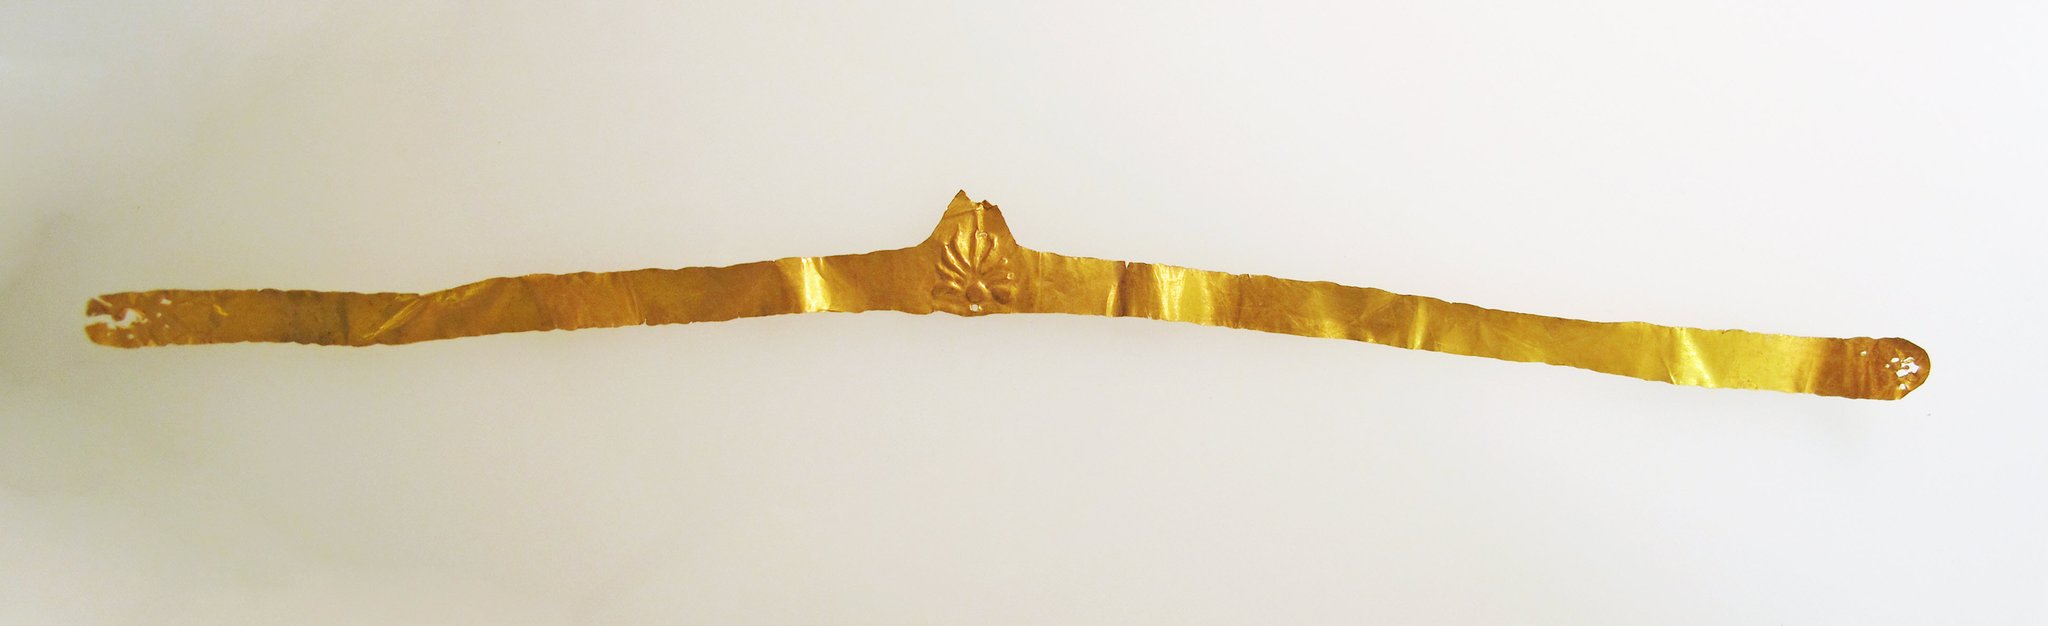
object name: frontlet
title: Frontlet of gold leaf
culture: cypriot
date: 400-301 BCE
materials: gold